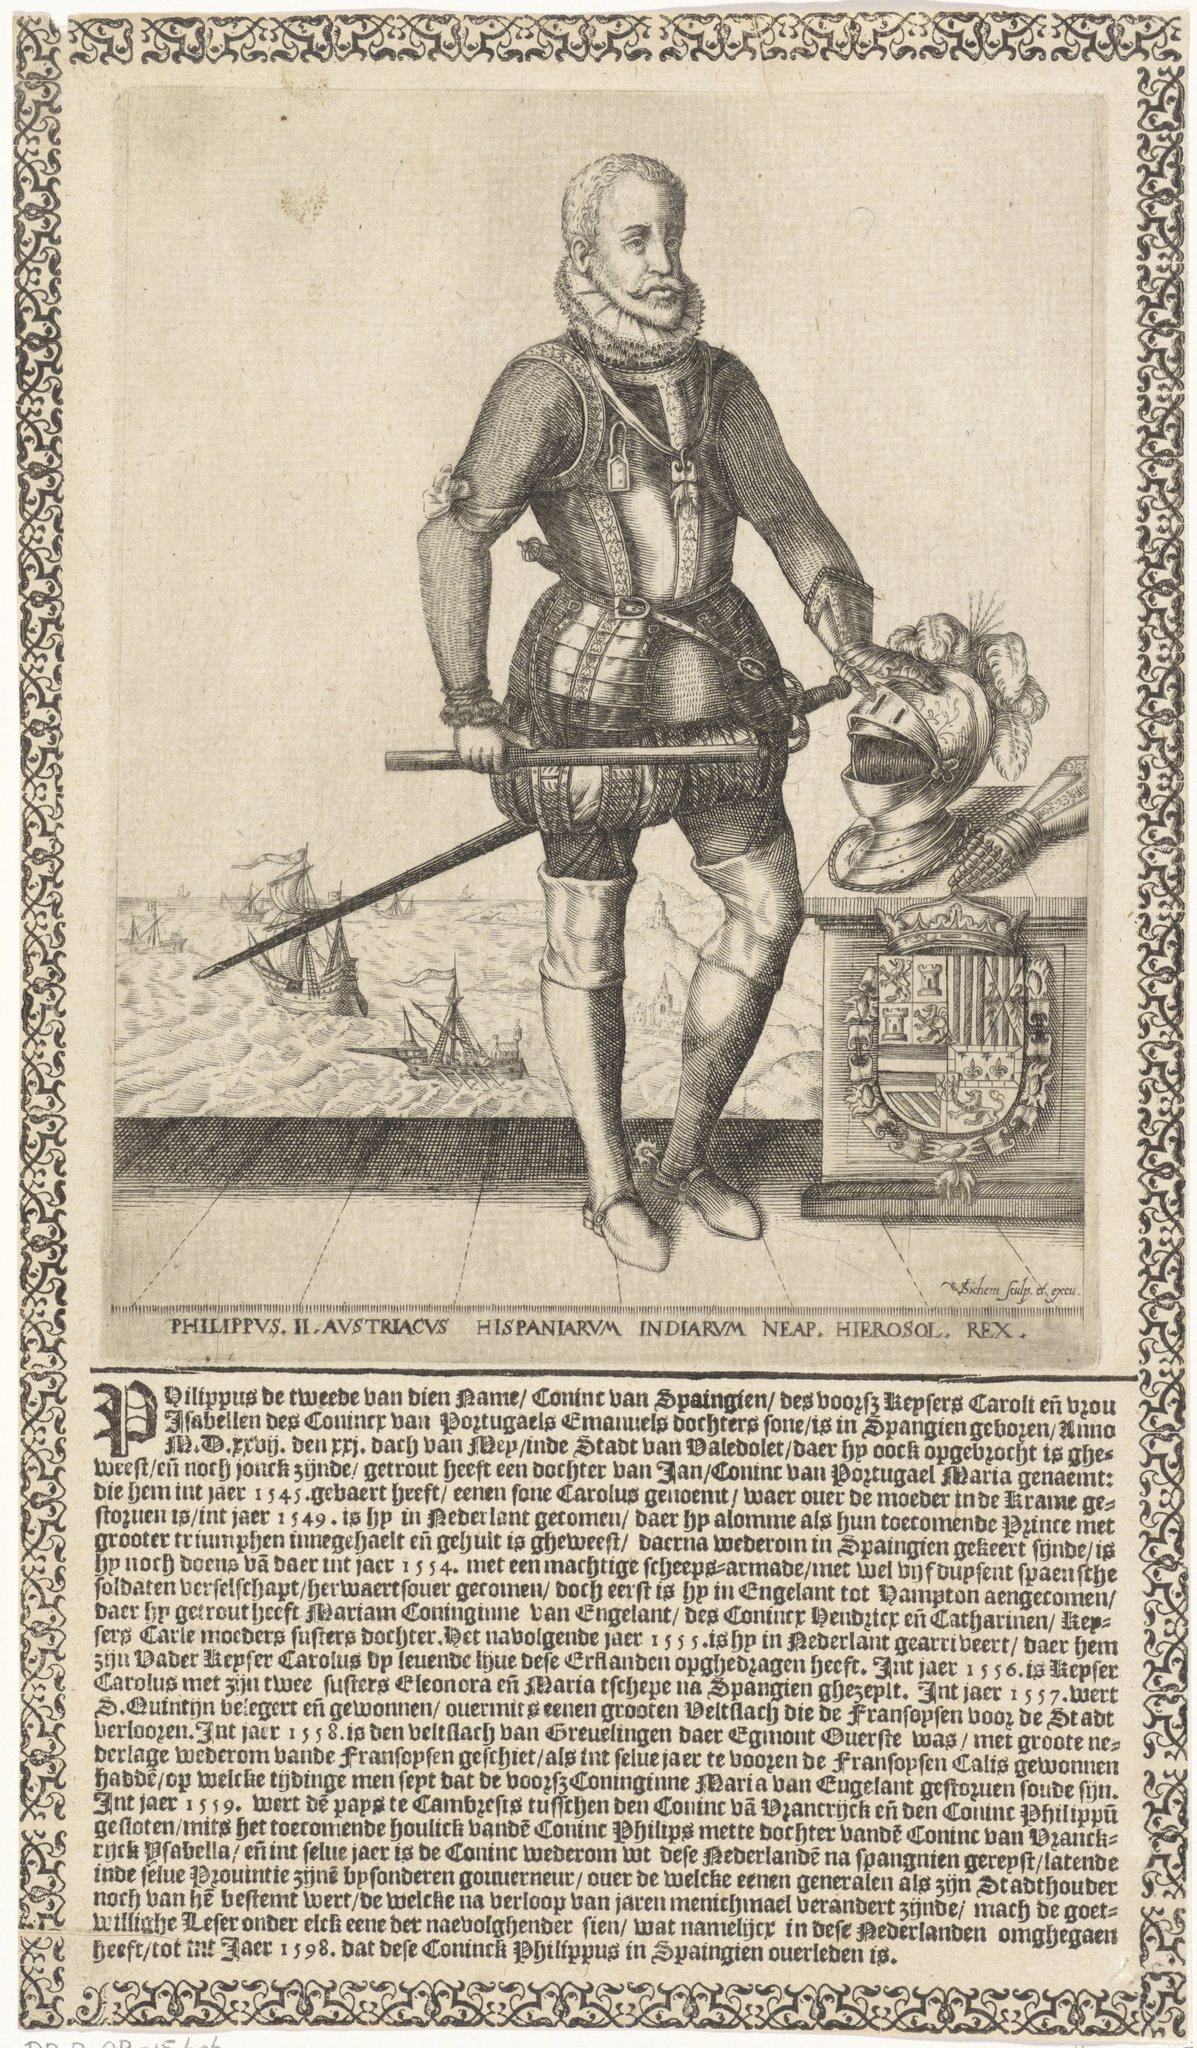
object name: print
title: Portret van Filips II, koning van Spanje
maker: christoffel van sichem (i)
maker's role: print maker, publisher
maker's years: 1546-1624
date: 1611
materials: paper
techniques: engraving, etching, letterpress printing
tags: philip ii of spain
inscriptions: collector's mark: Lugt 2228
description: Portret van Filips II, koning van Spanje. Hij heeft een commando-staf in de hand en staat naast een voetstuk met daarop zijn helm en de handschoenen van zijn harnas. Op het voetstuk zijn wapenschild. Op de achtergrond een zeezicht. Onder het portret in het Latijn zijn naam en functie. Onder de prent Nederlandse tekst in boekdruk. Rondom een ornamentele omlijsting.